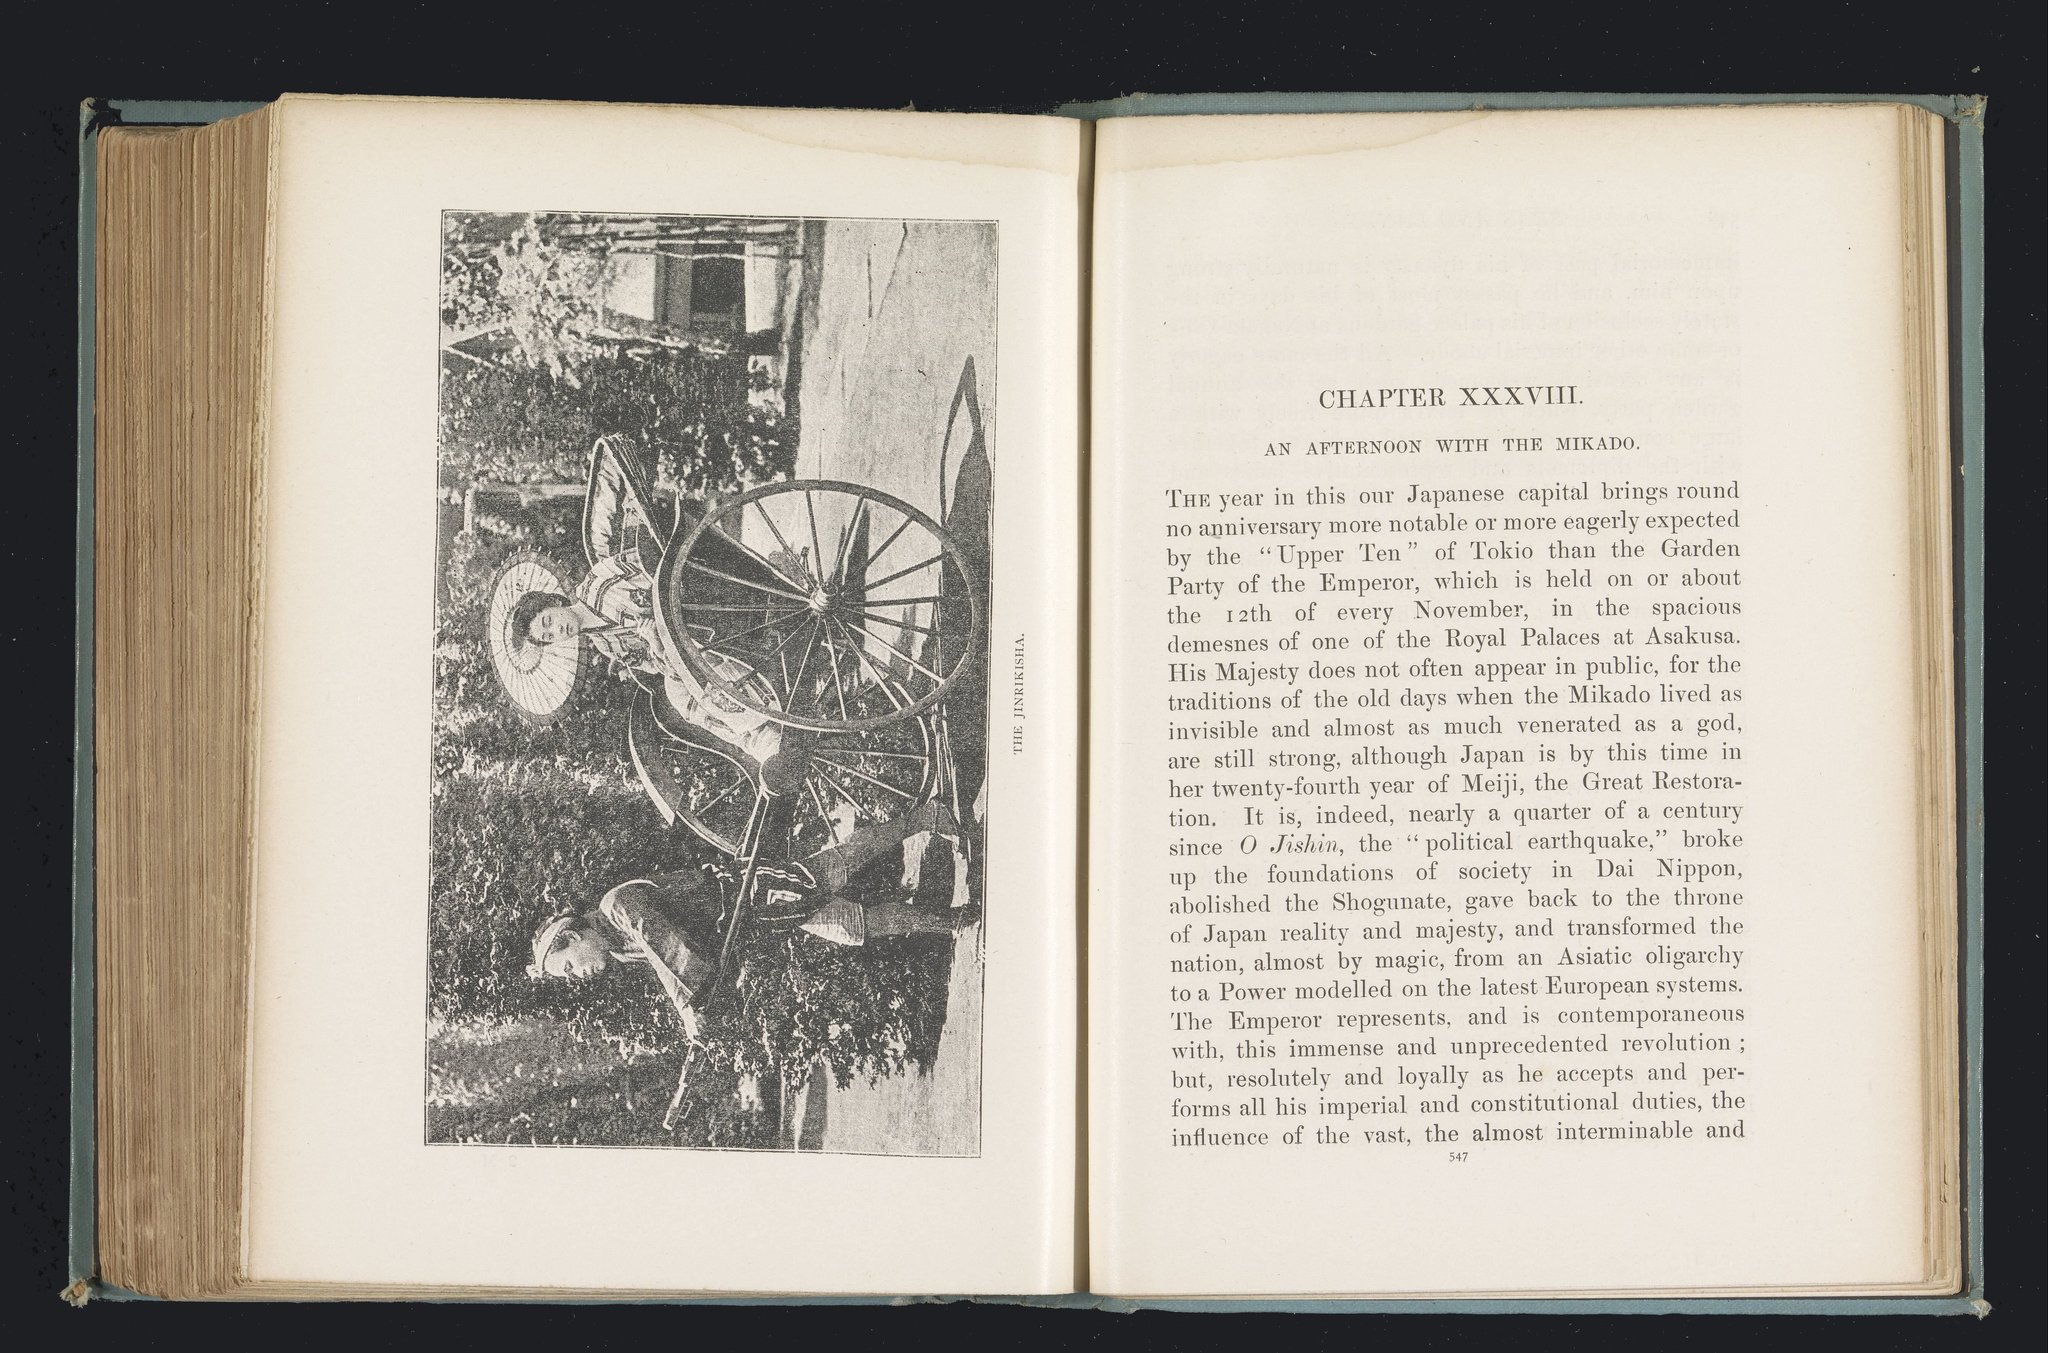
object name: page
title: The Jinrikisha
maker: Anonymous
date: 1882-1892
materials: paper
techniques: autotype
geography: japan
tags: rickshaw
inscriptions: number: ‘2 M’